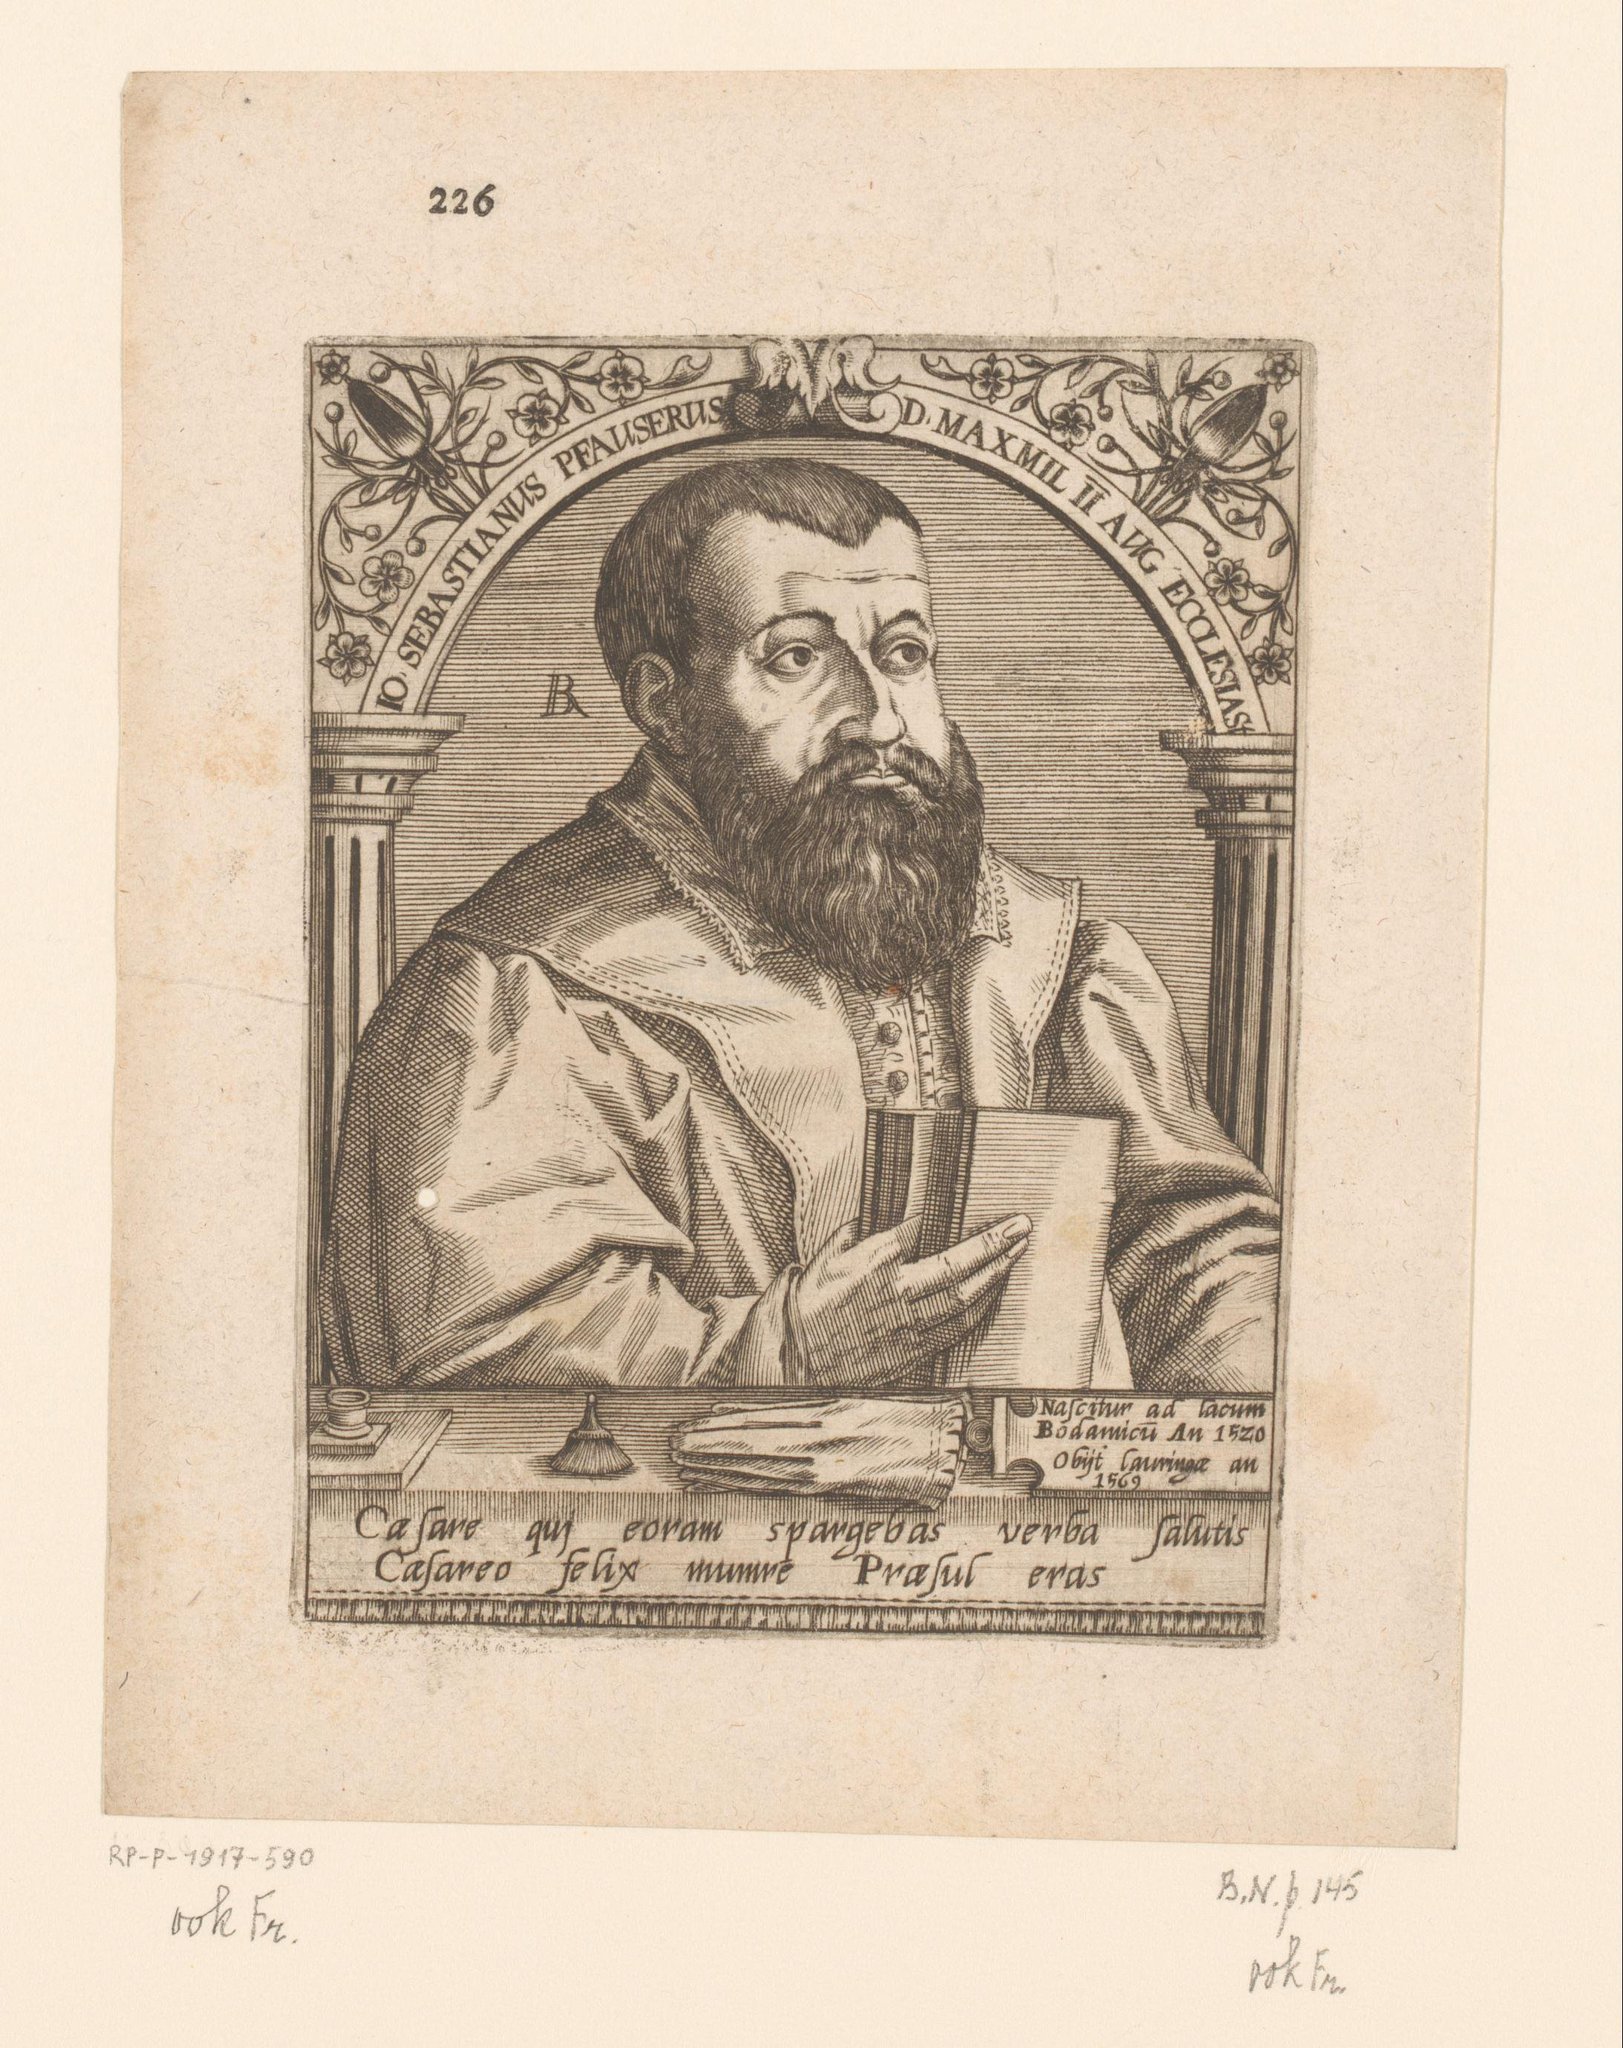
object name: book illustration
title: Serie portretten van vijftiende- en zestiende-eeuwse geleerden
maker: robert boissard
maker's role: print maker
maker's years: 1570-1611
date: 1597-1599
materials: paper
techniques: engraving, letterpress printing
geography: france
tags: gloves, mittens, etc., historical persons, book, insects: beetle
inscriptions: collector's mark: Lugt 2228